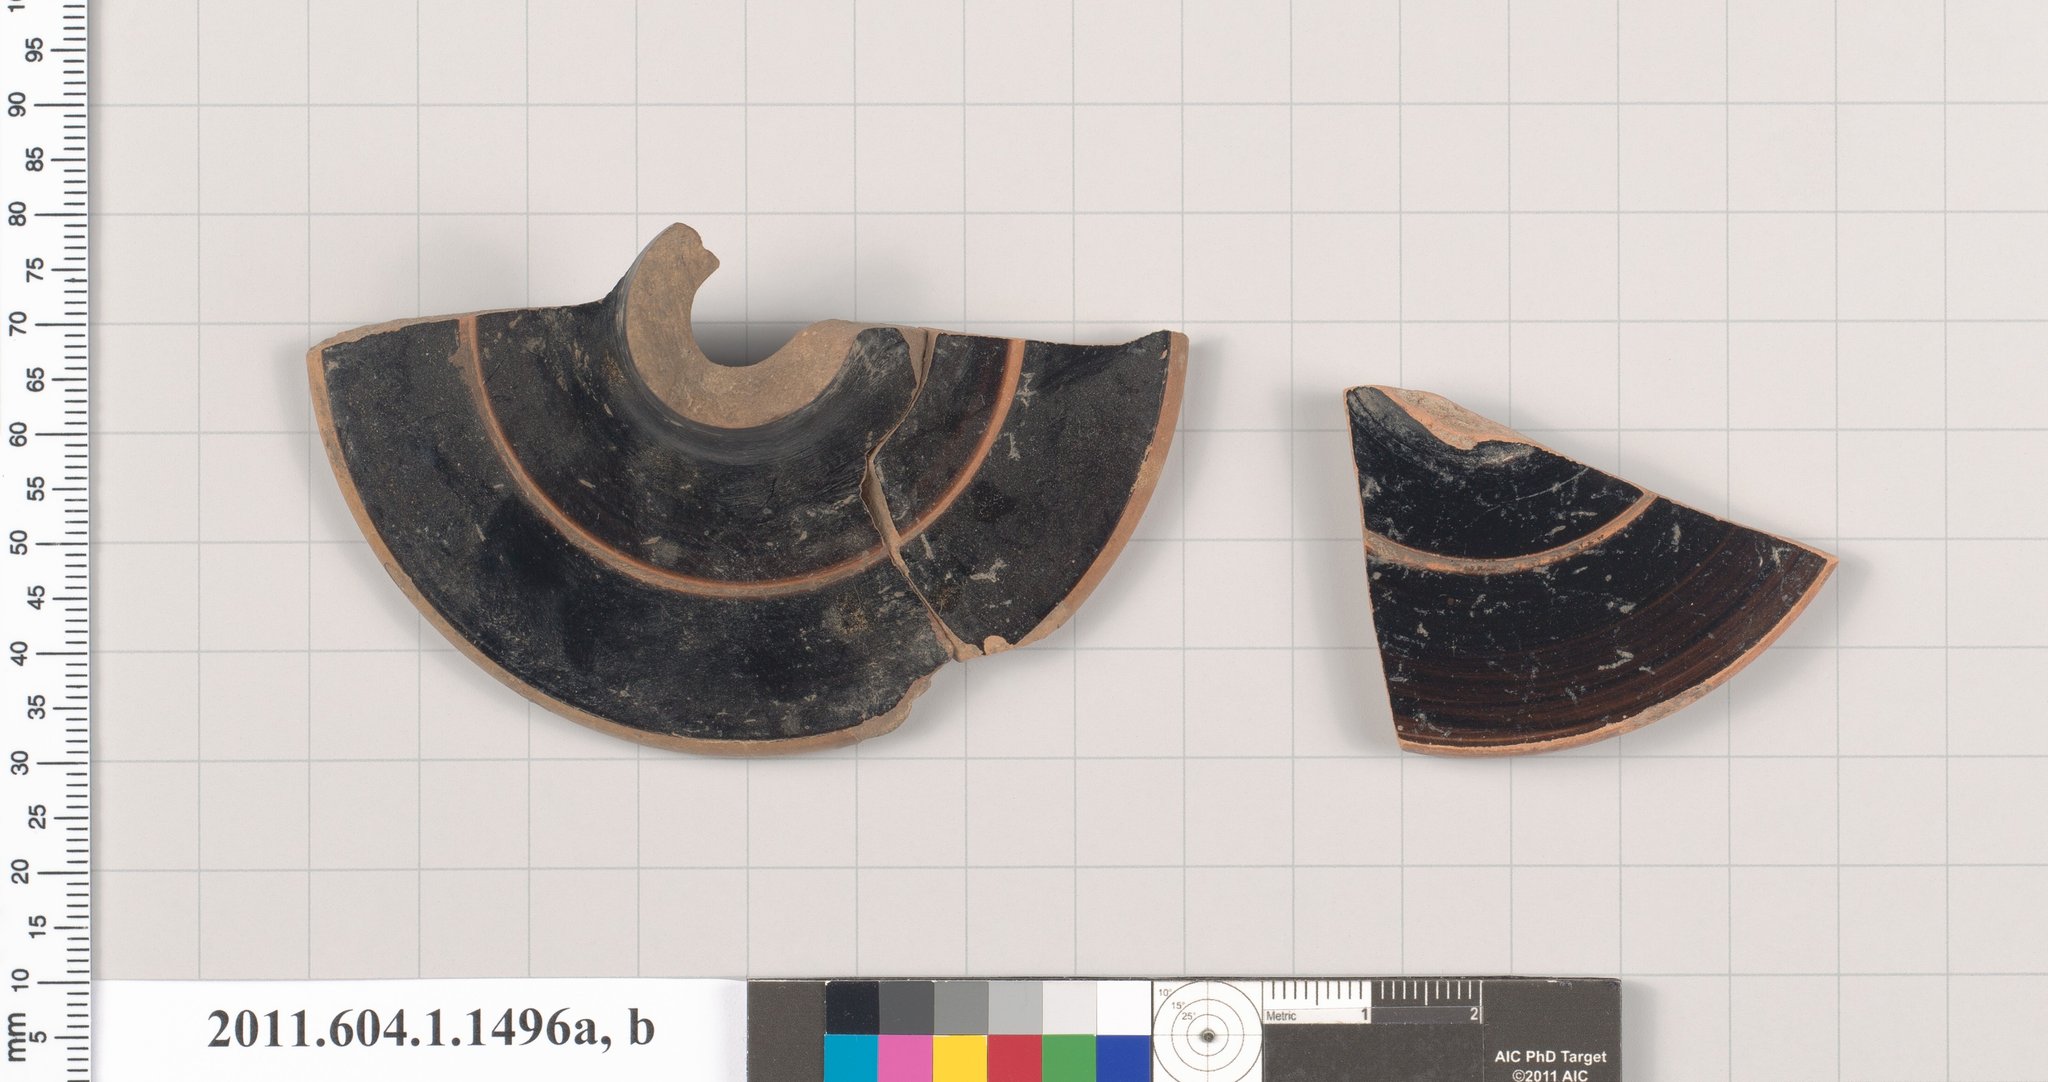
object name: kylix fragment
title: Terracotta fragments of kylikes (drinking cups)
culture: greek, attic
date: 500-401 BCE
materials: terracotta